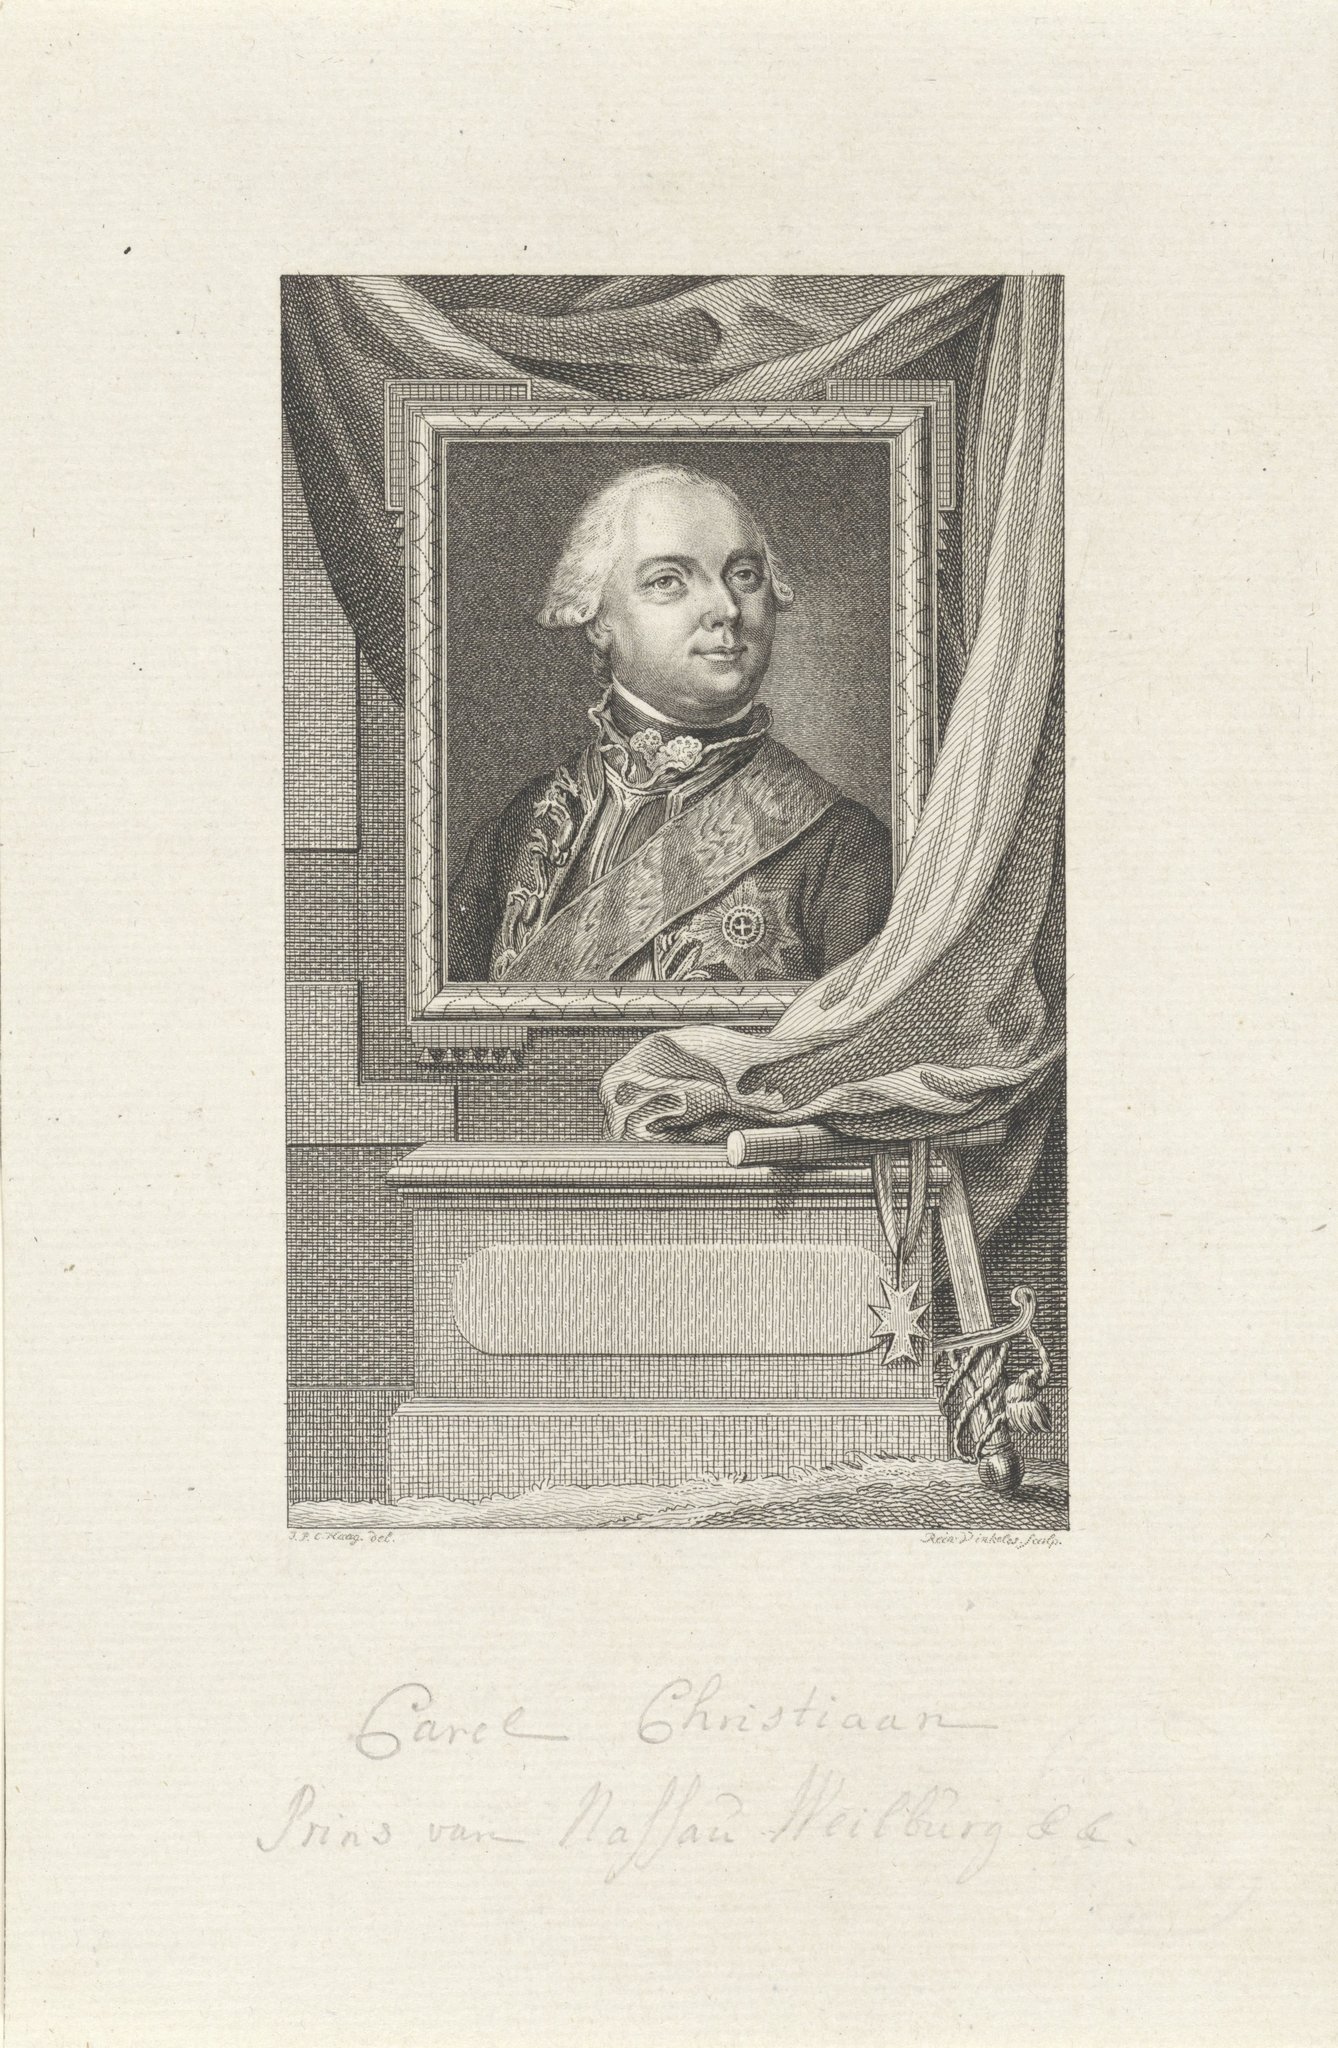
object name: print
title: Portret van Karel Christiaan, vorst van Nassau-Weilburg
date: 1786-1809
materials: paper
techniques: etching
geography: amsterdam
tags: karel christiaan vorst van nassau-weilburg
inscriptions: collector's mark: Lugt 240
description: Latere staat prent vermoedelijk gebruikt als boekillustratie in: Wagenaar, Jan. Vaderlandsche historie, (...) ten vervolge van Wagenaars Vaderlandsche historie. Dl. 1-43. Amsterdam: Johannes Allart, 1786-1809.